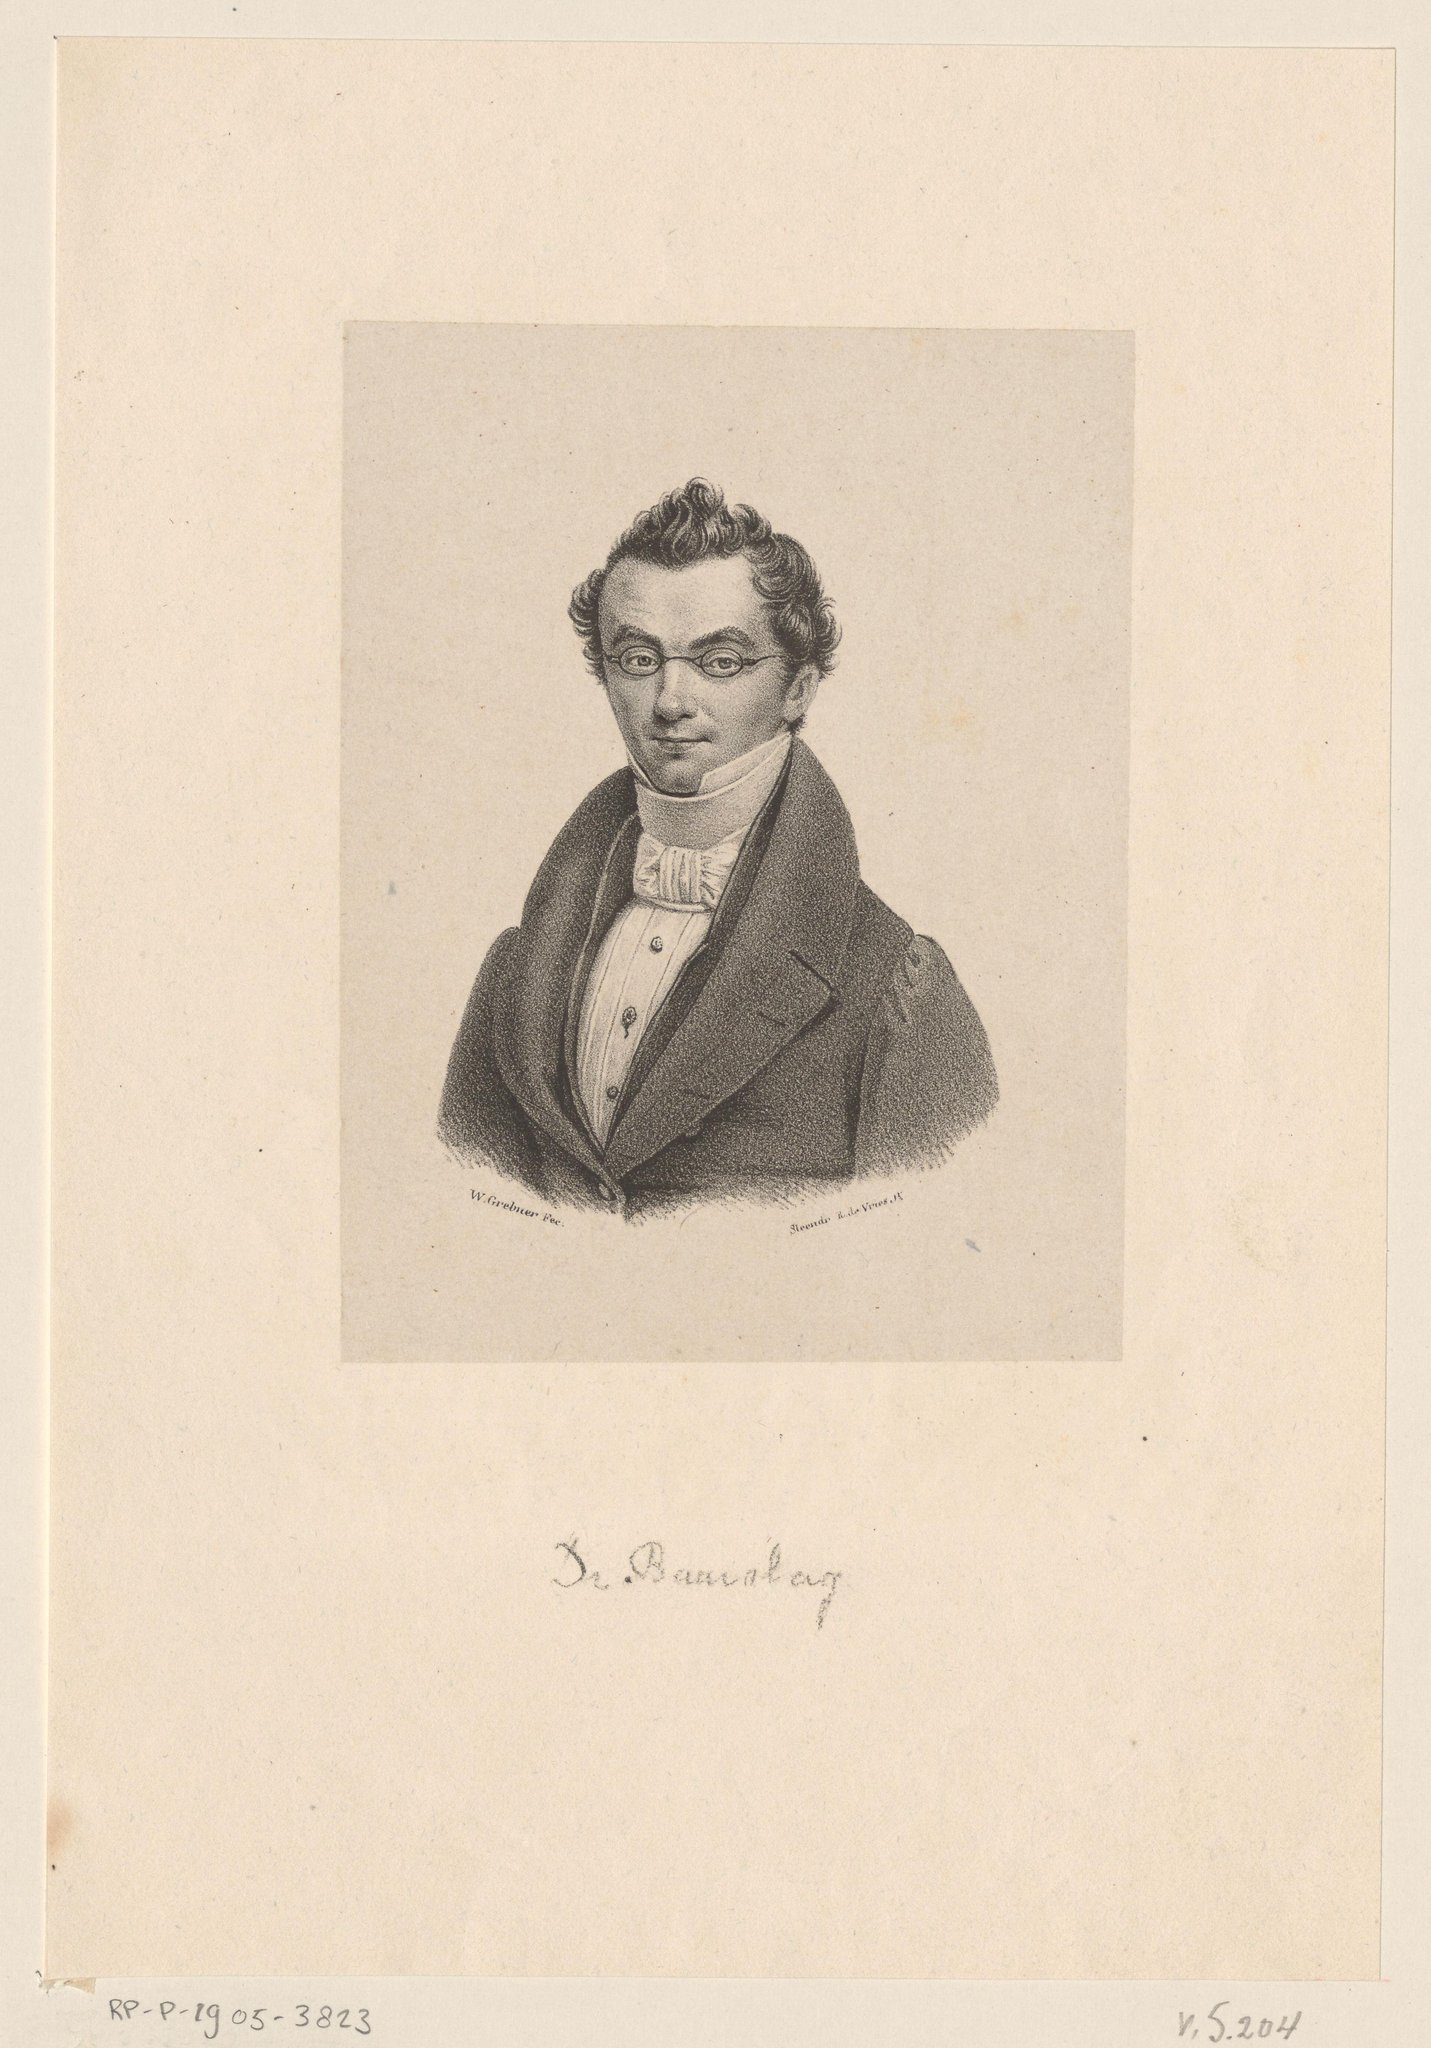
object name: print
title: Portret van W. Baarslag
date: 1834-1866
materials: paper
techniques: lithograph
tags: historical persons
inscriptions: collector's mark: Lugt 2228